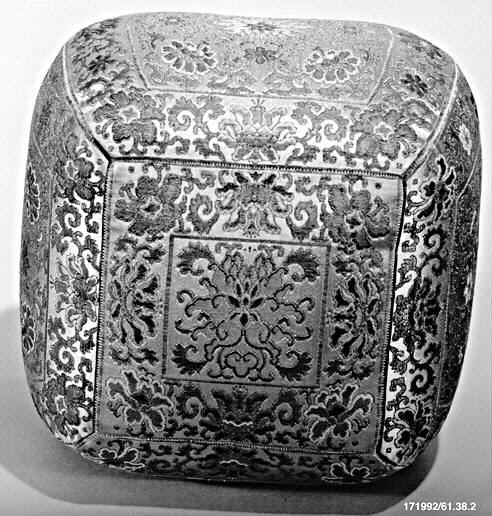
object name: cushion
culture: chinese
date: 1867-1900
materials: silk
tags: flowers